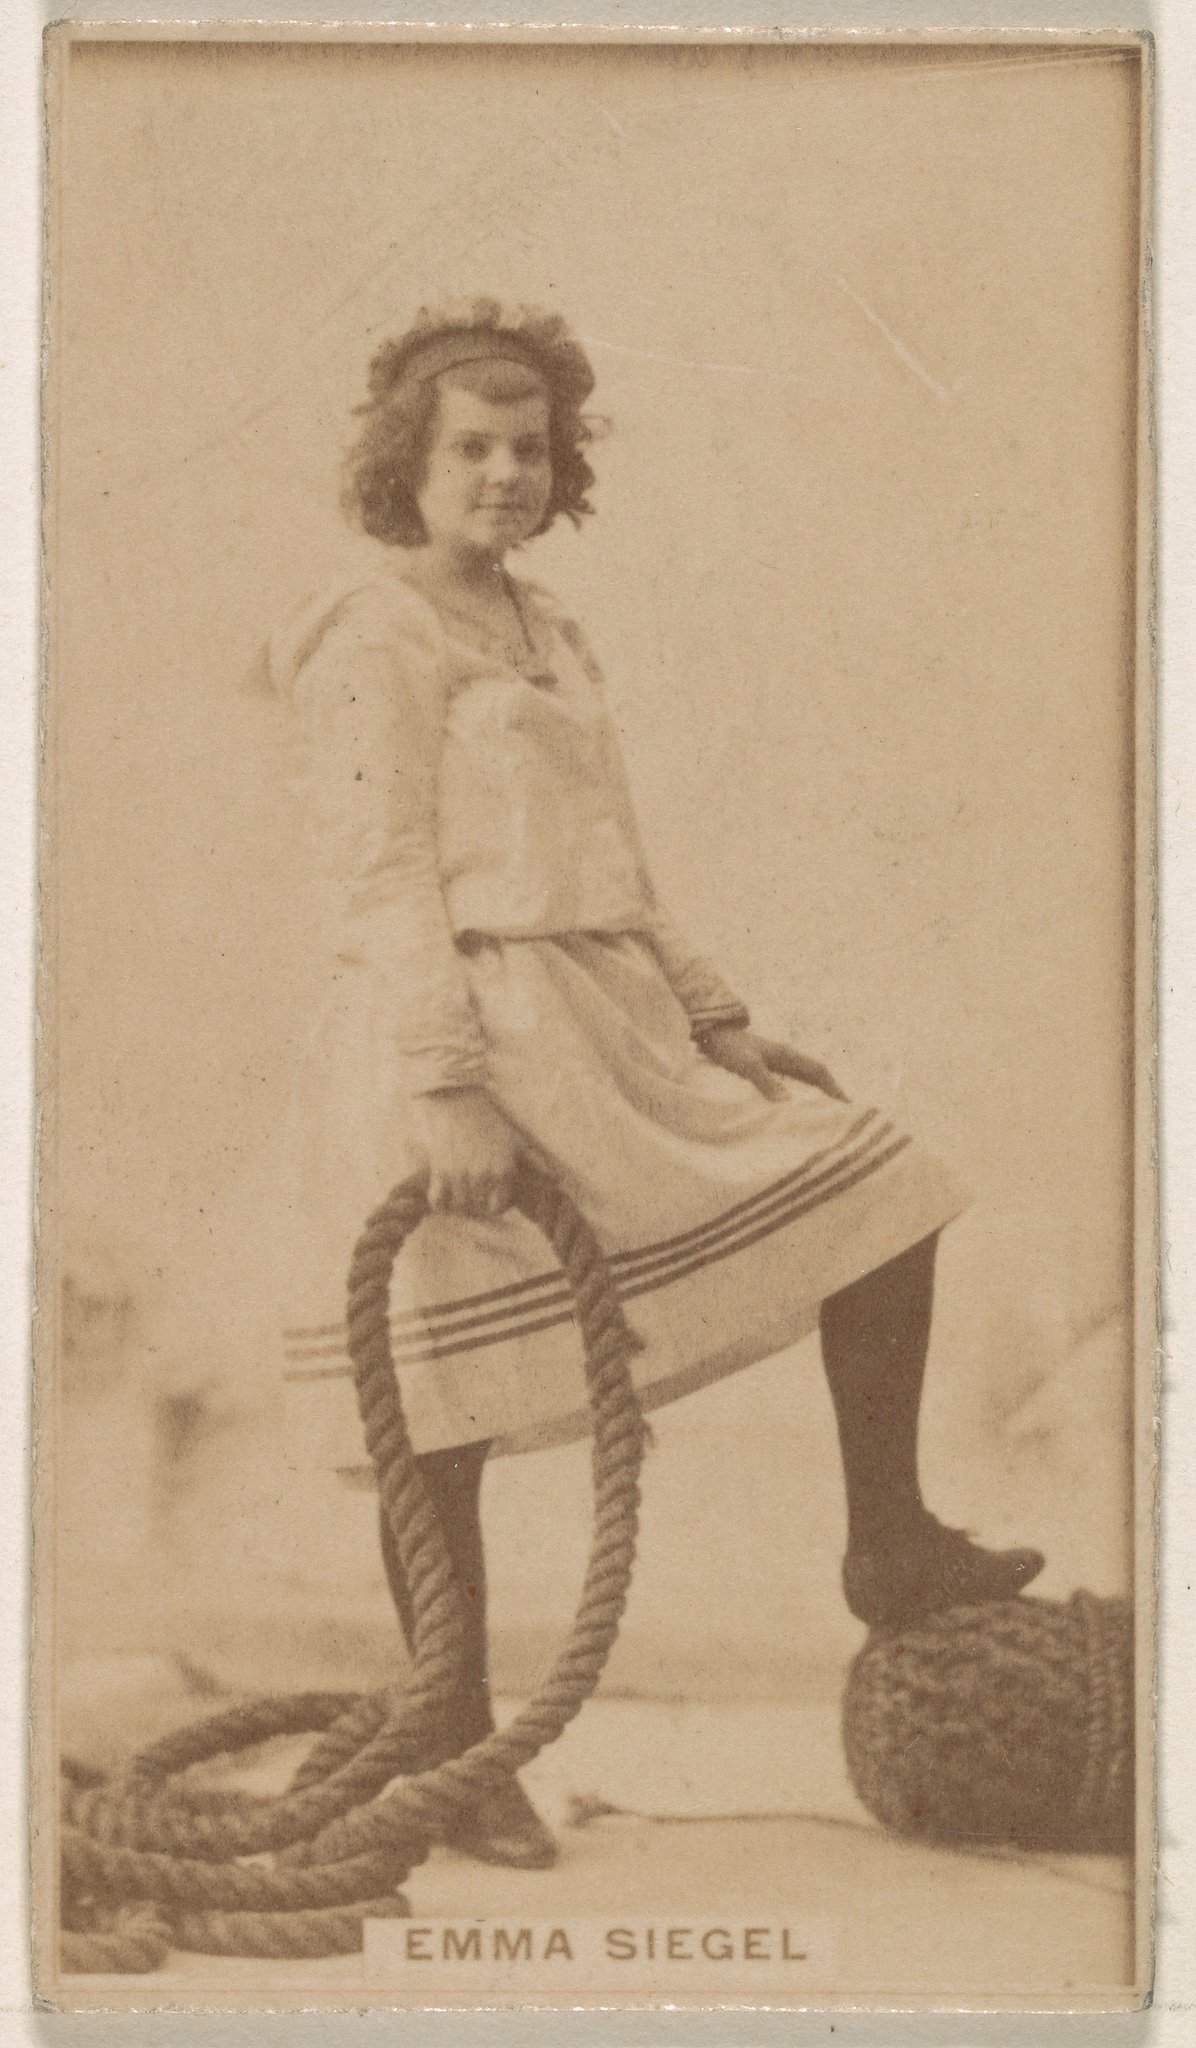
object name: photograph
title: Emma Siegel, from the Actresses series (N245) issued by Kinney Brothers to promote Sweet Caporal Cigarettes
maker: kinney brothers tobacco company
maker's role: publisher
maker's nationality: american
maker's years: 1869-2011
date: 1890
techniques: albumen silver print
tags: girls,portraits,actresses